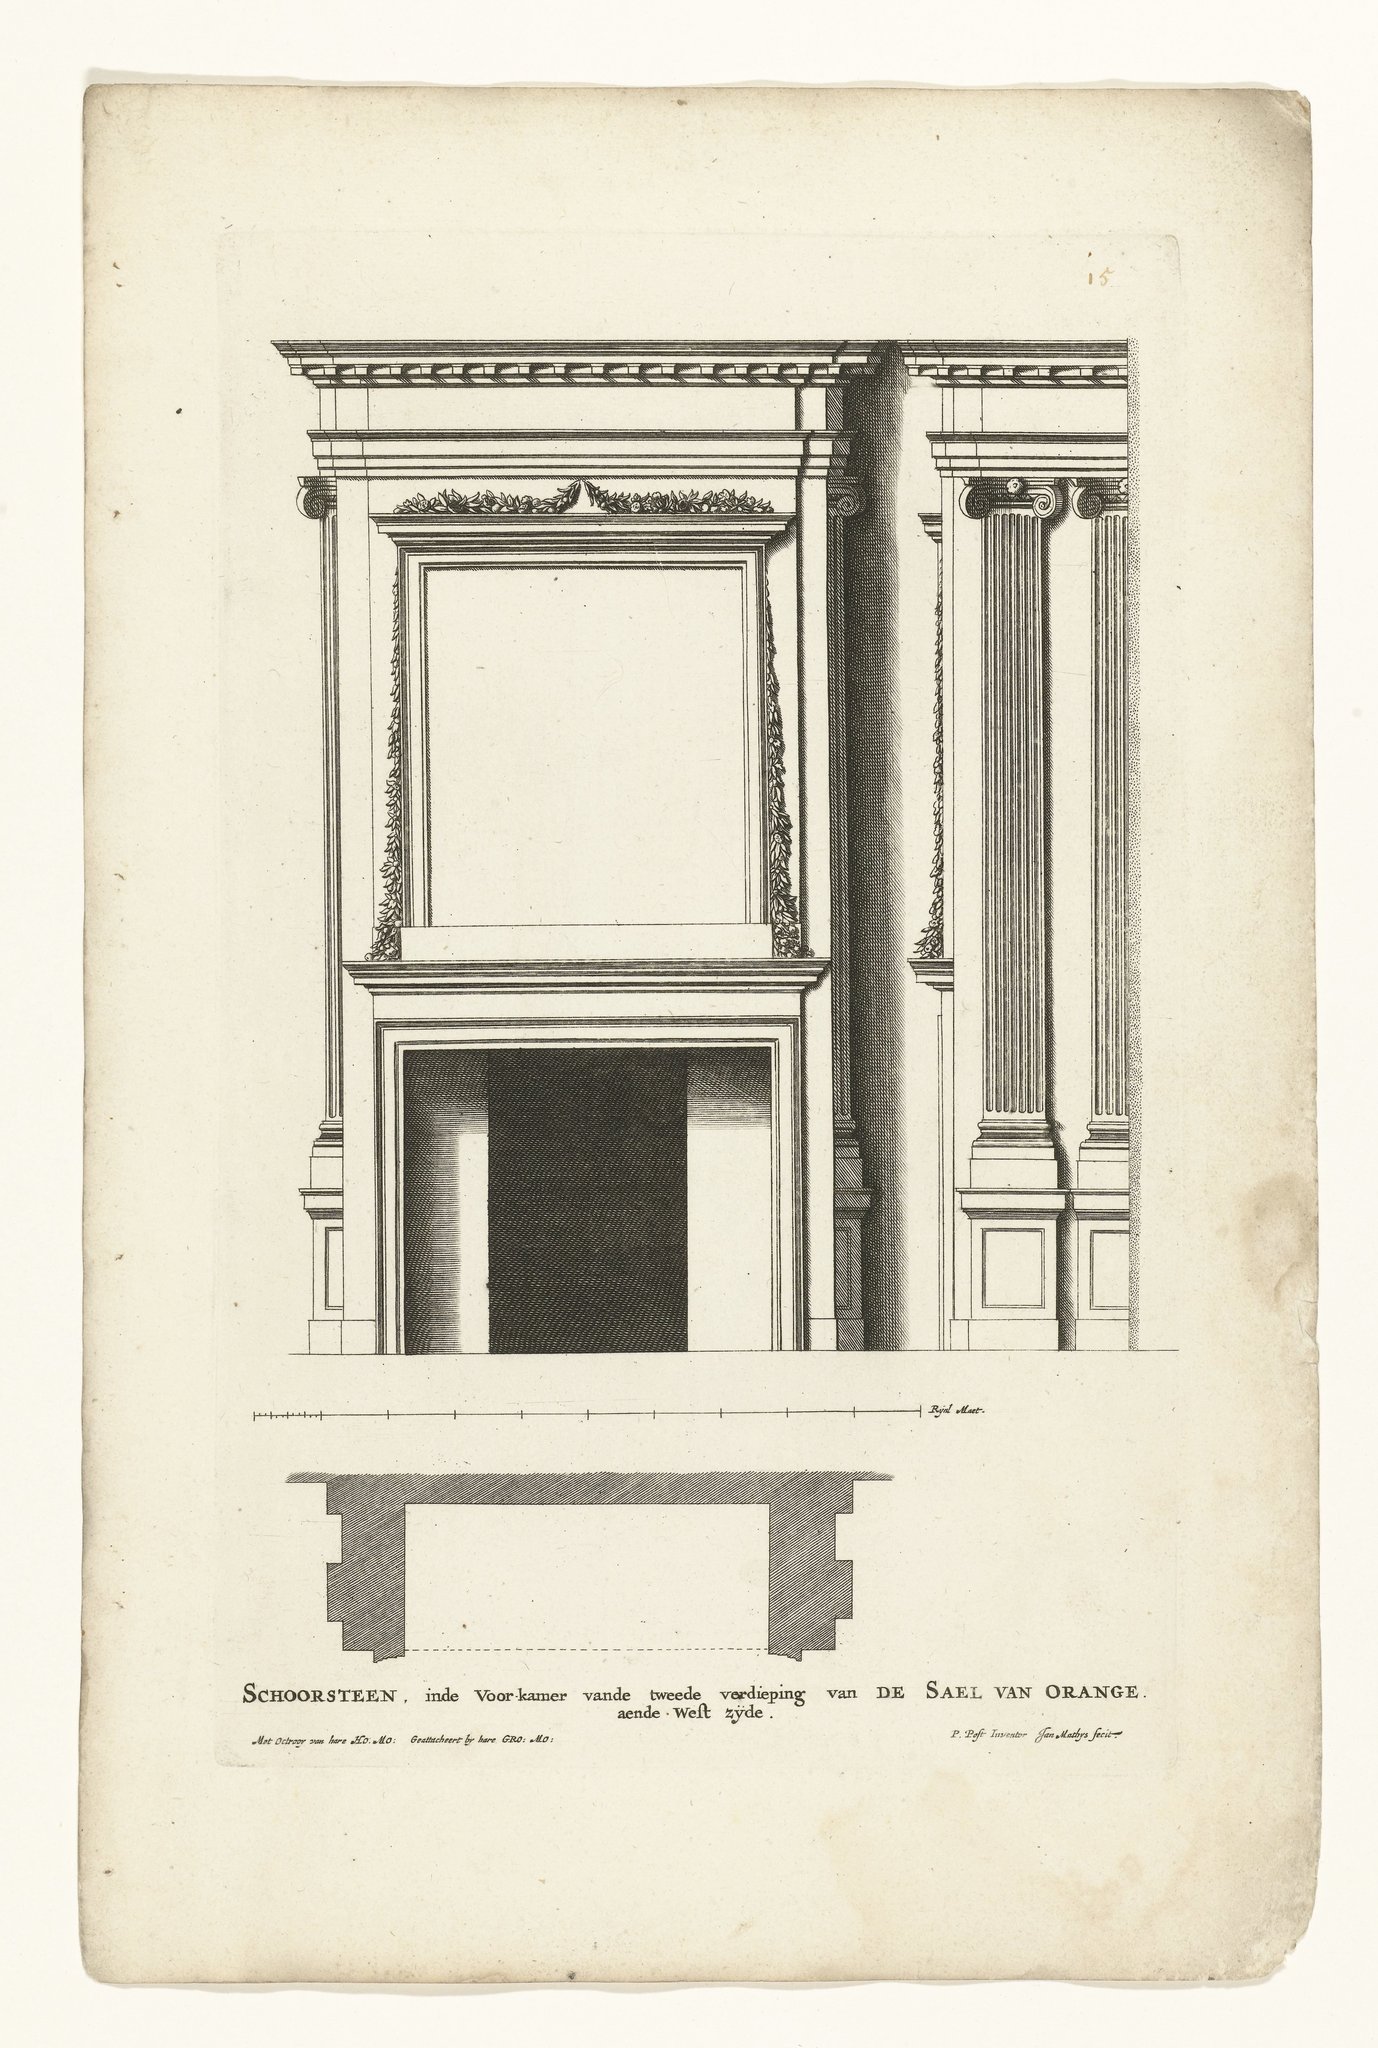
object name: print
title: Schoorsteen, inde Voor-kamer vande tweede verdieping, van de Sael van Orange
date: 1664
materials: paper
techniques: engraving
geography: the hague